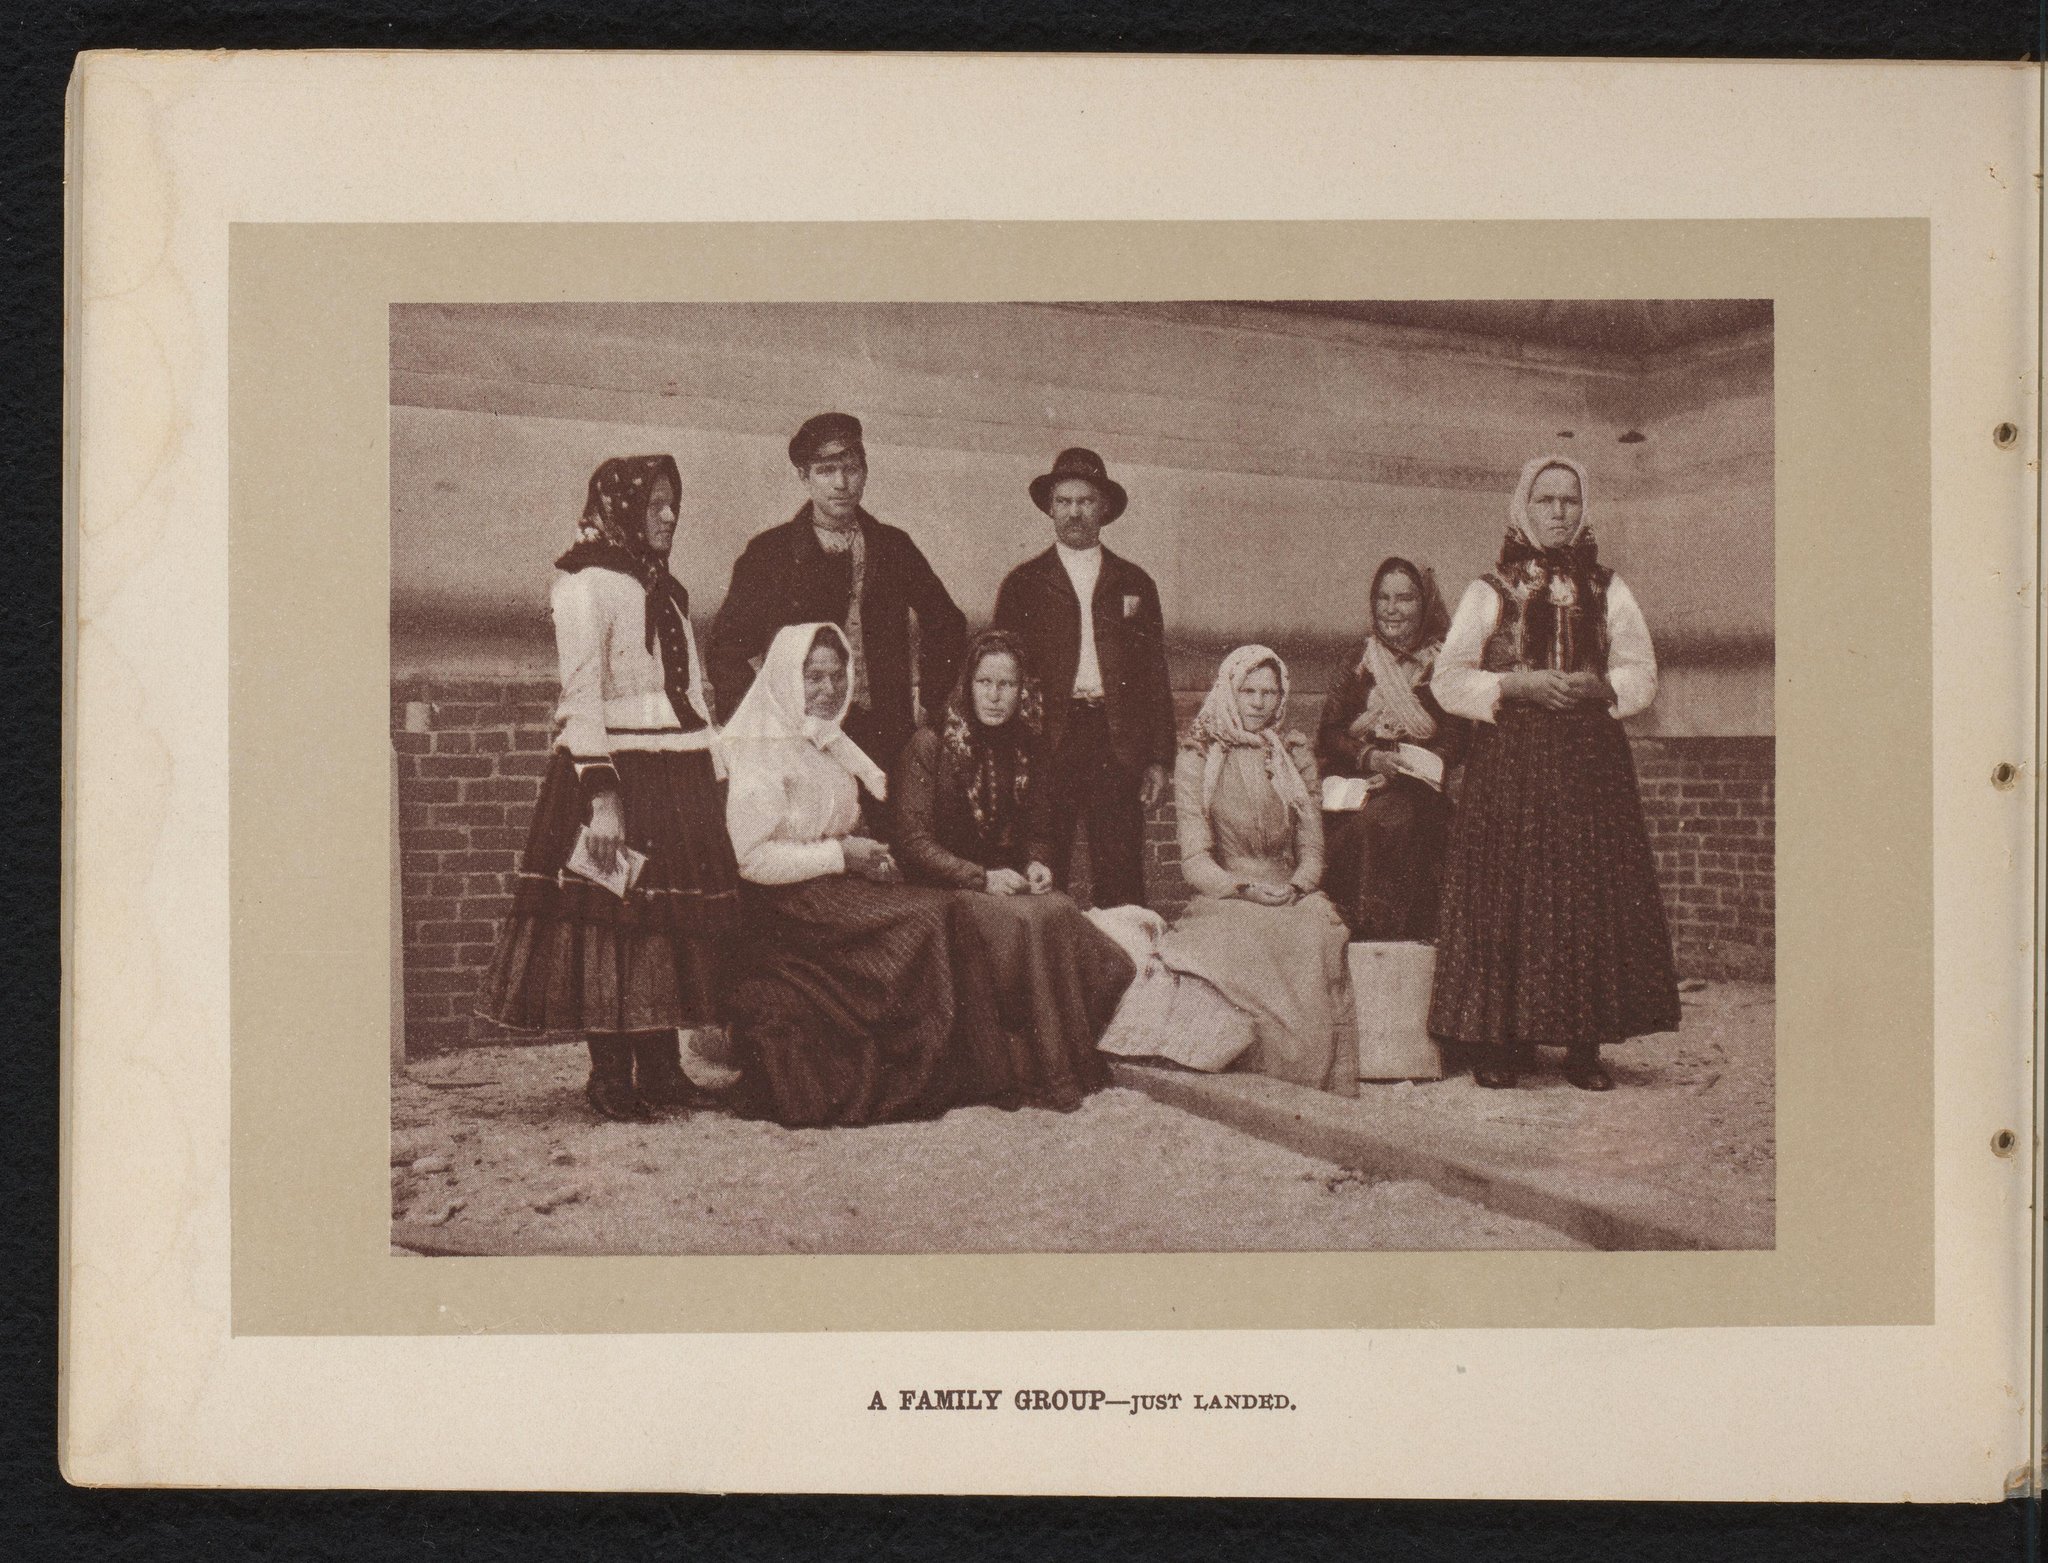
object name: photomechanical print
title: A family group - just landed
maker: Anonymous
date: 1897-1902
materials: paper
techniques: autotype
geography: new york city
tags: (descendants of) european emigrants to america, family relationships (first, second, third and fourth degree), generations, historical persons not known by name, new york (city)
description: Prent op eenendertigste ongenummerde pagina.